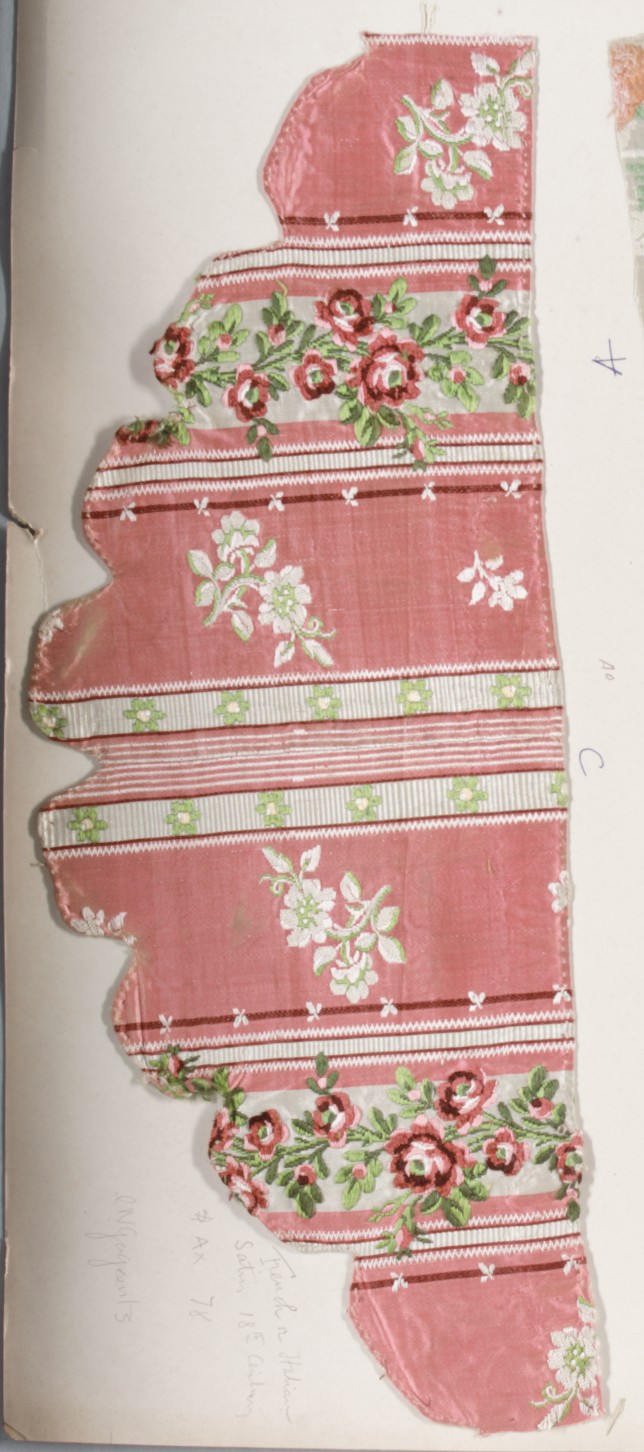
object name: fragment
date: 1701-1800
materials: silk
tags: flowers,leaves